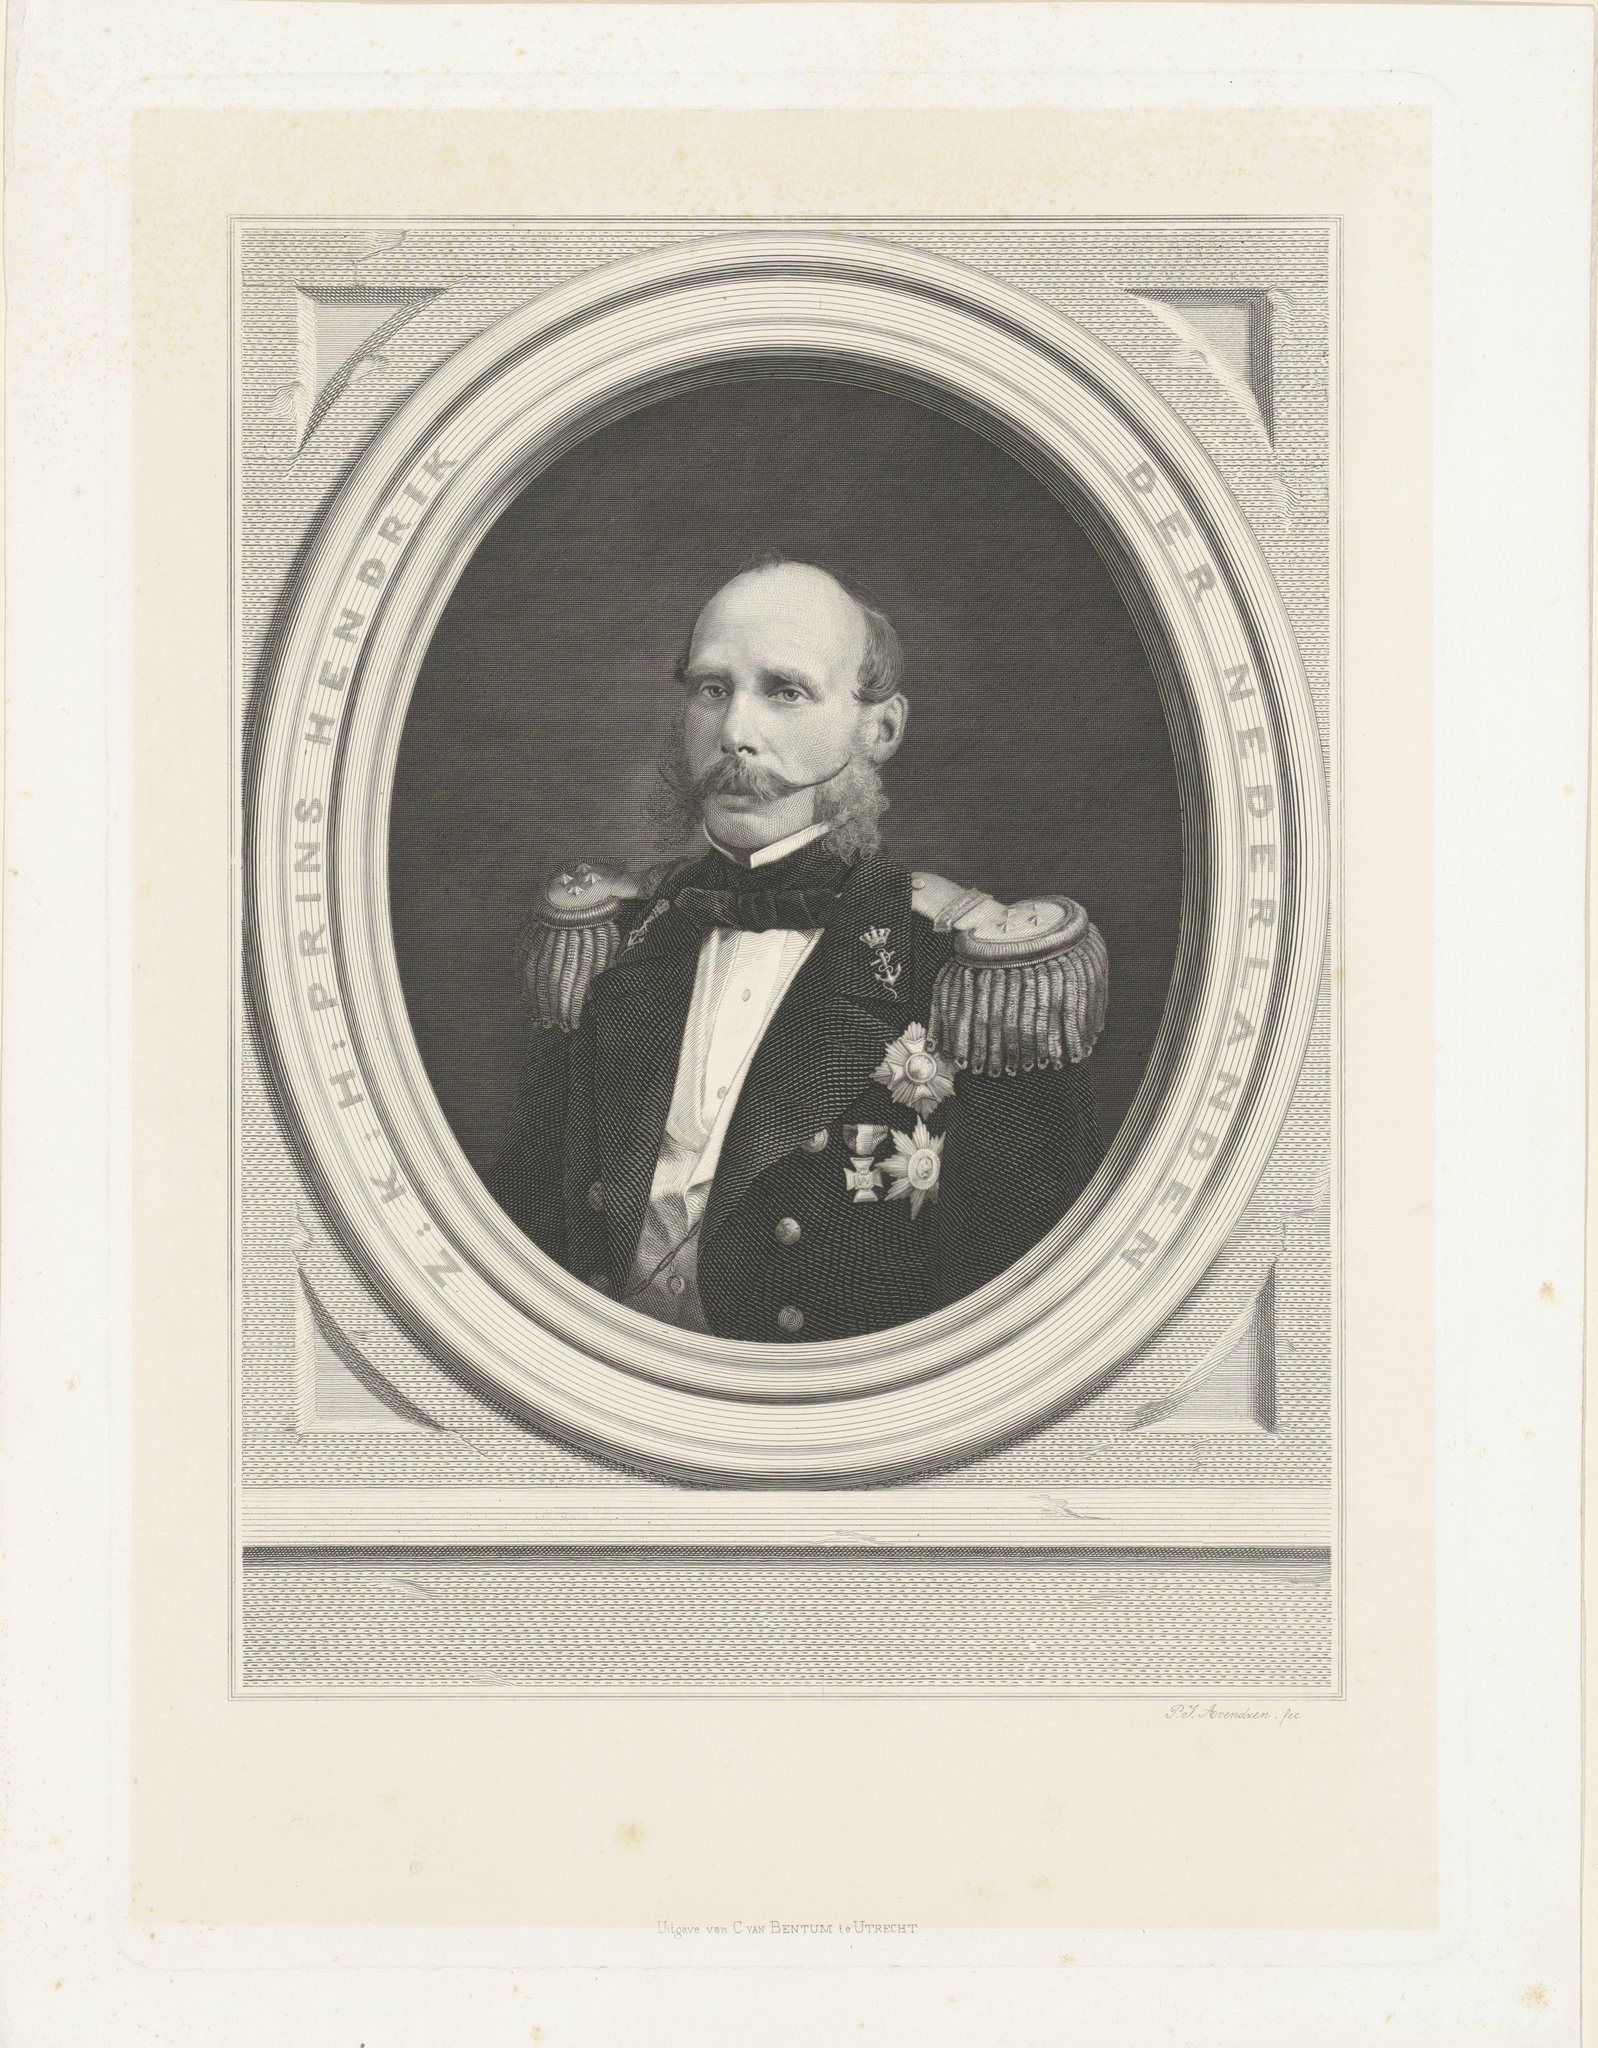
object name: print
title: Portret van Hendrik, prins der Nederlanden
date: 1873-1904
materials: paper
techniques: engraving, etching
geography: amsterdam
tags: hendrik (prins der nederlanden)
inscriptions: collector's mark: Lugt 2228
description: De hier vermelde titel verwijst naar de hoogst verkregen titel van de geportretteerde, niet per se naar de titel die de geportretteerde op deze voorstelling draagt.